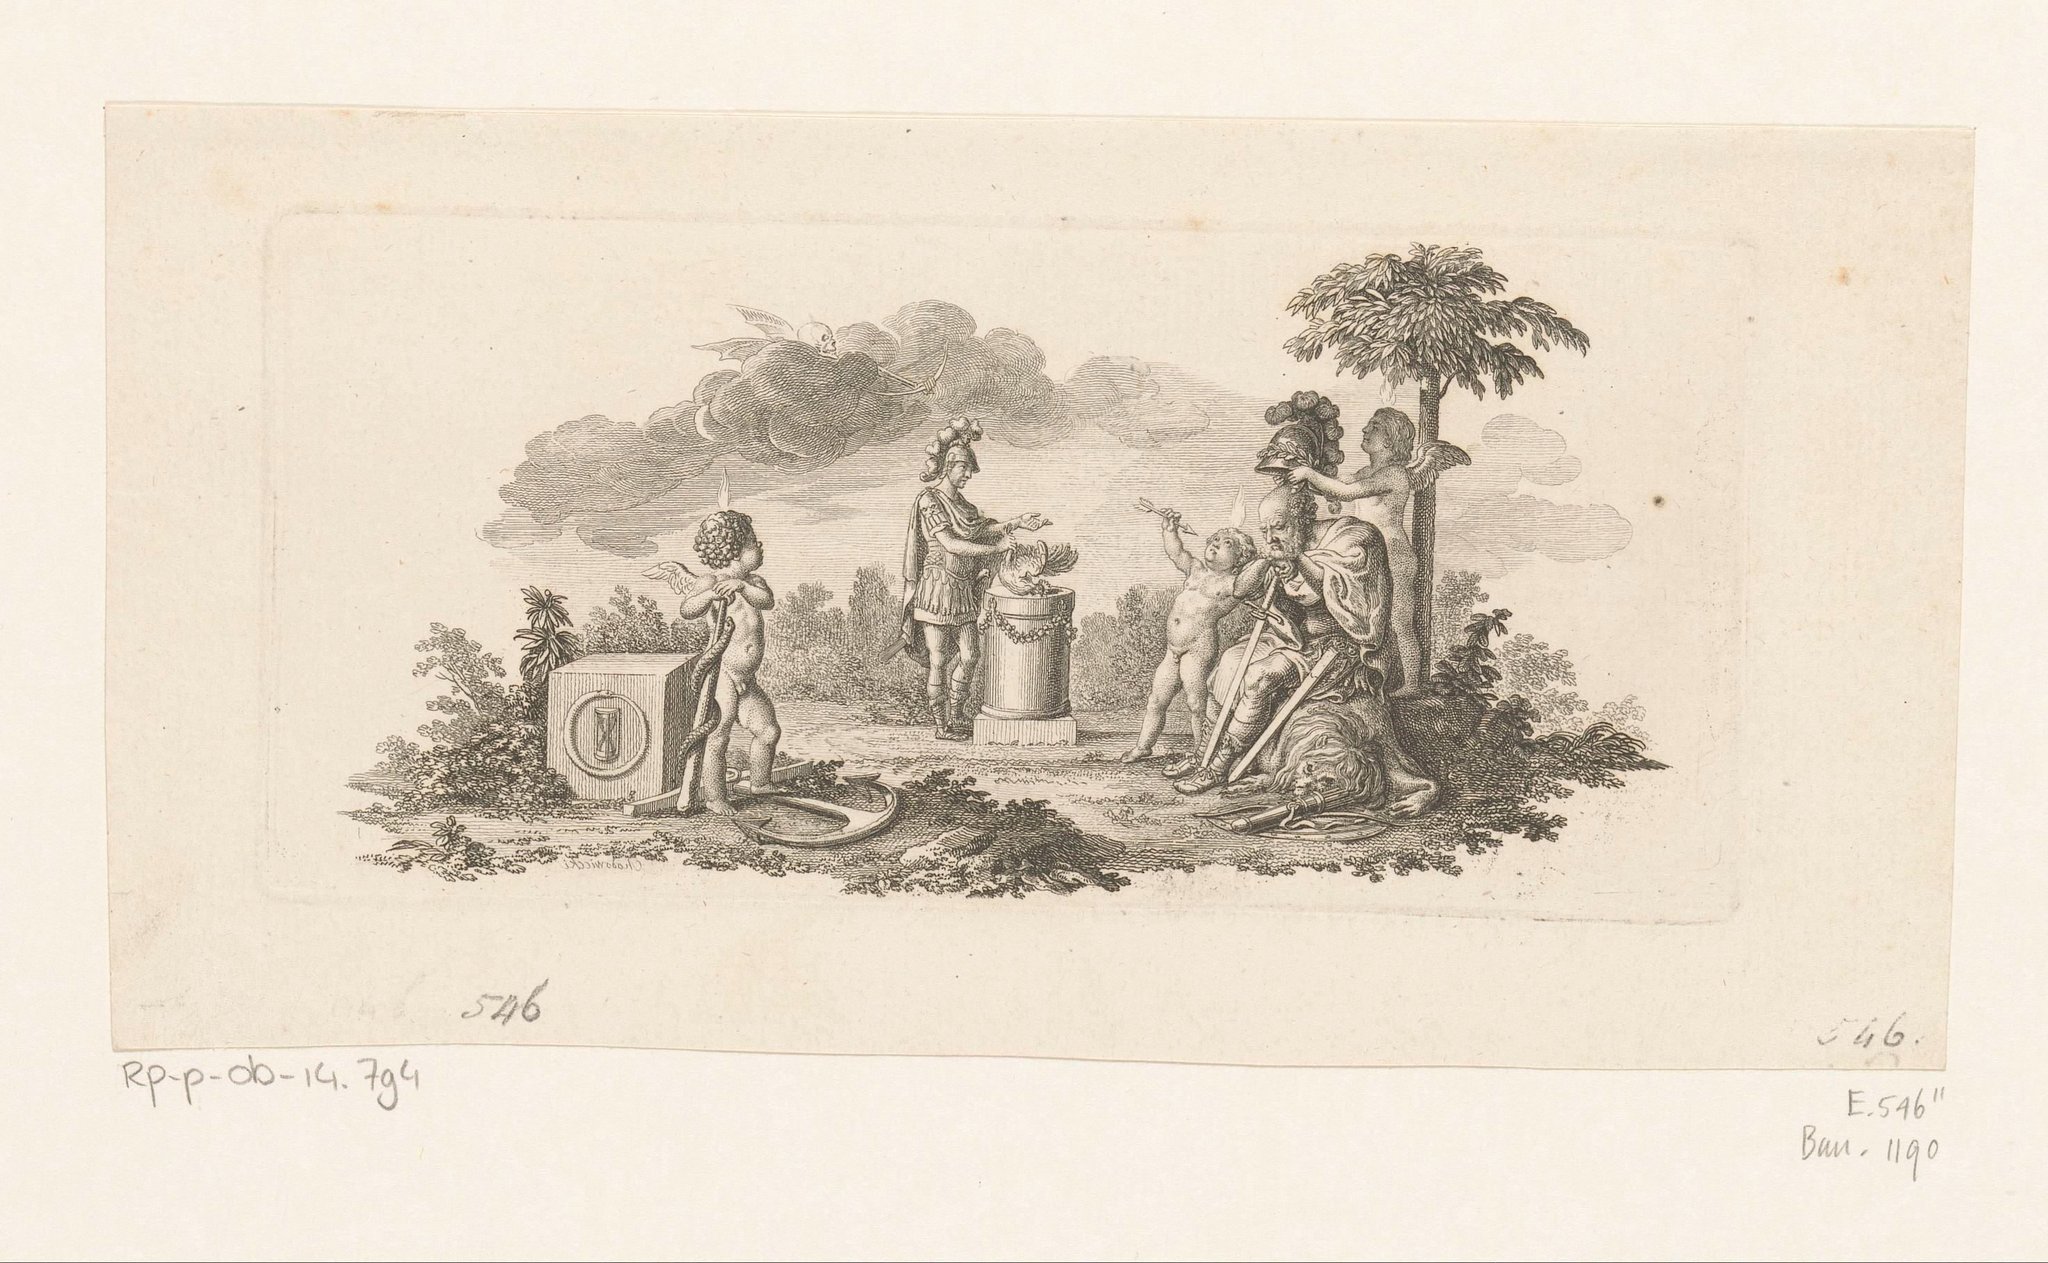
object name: print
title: Allegorie op goed bevelhebberschap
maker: daniel nikolaus chodowiecki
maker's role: draughtsman, print maker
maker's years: 1726-1801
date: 1785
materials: paper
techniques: etching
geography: berlin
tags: death as skeleton (+ death with bow and arrow), hope, 'spes'; 'speranza divina e certa' (ripa) ~ one of the three theological virtues, commander-in-chief, general, marshal, beasts of prey, predatory animals: lion (+ animals used symbolically), hourglass, serpent ouroboros, cupids: 'amores', 'amoretti', 'putti', crowning the victor with laurel, animal sacrifice ~ non-christian religions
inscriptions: collector's mark: Lugt 2228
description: Prent gebruikt voor: Der Genesung ihres verehrungswürdigsten Befehlhabers (...). Berlijn: s.n., 1785.